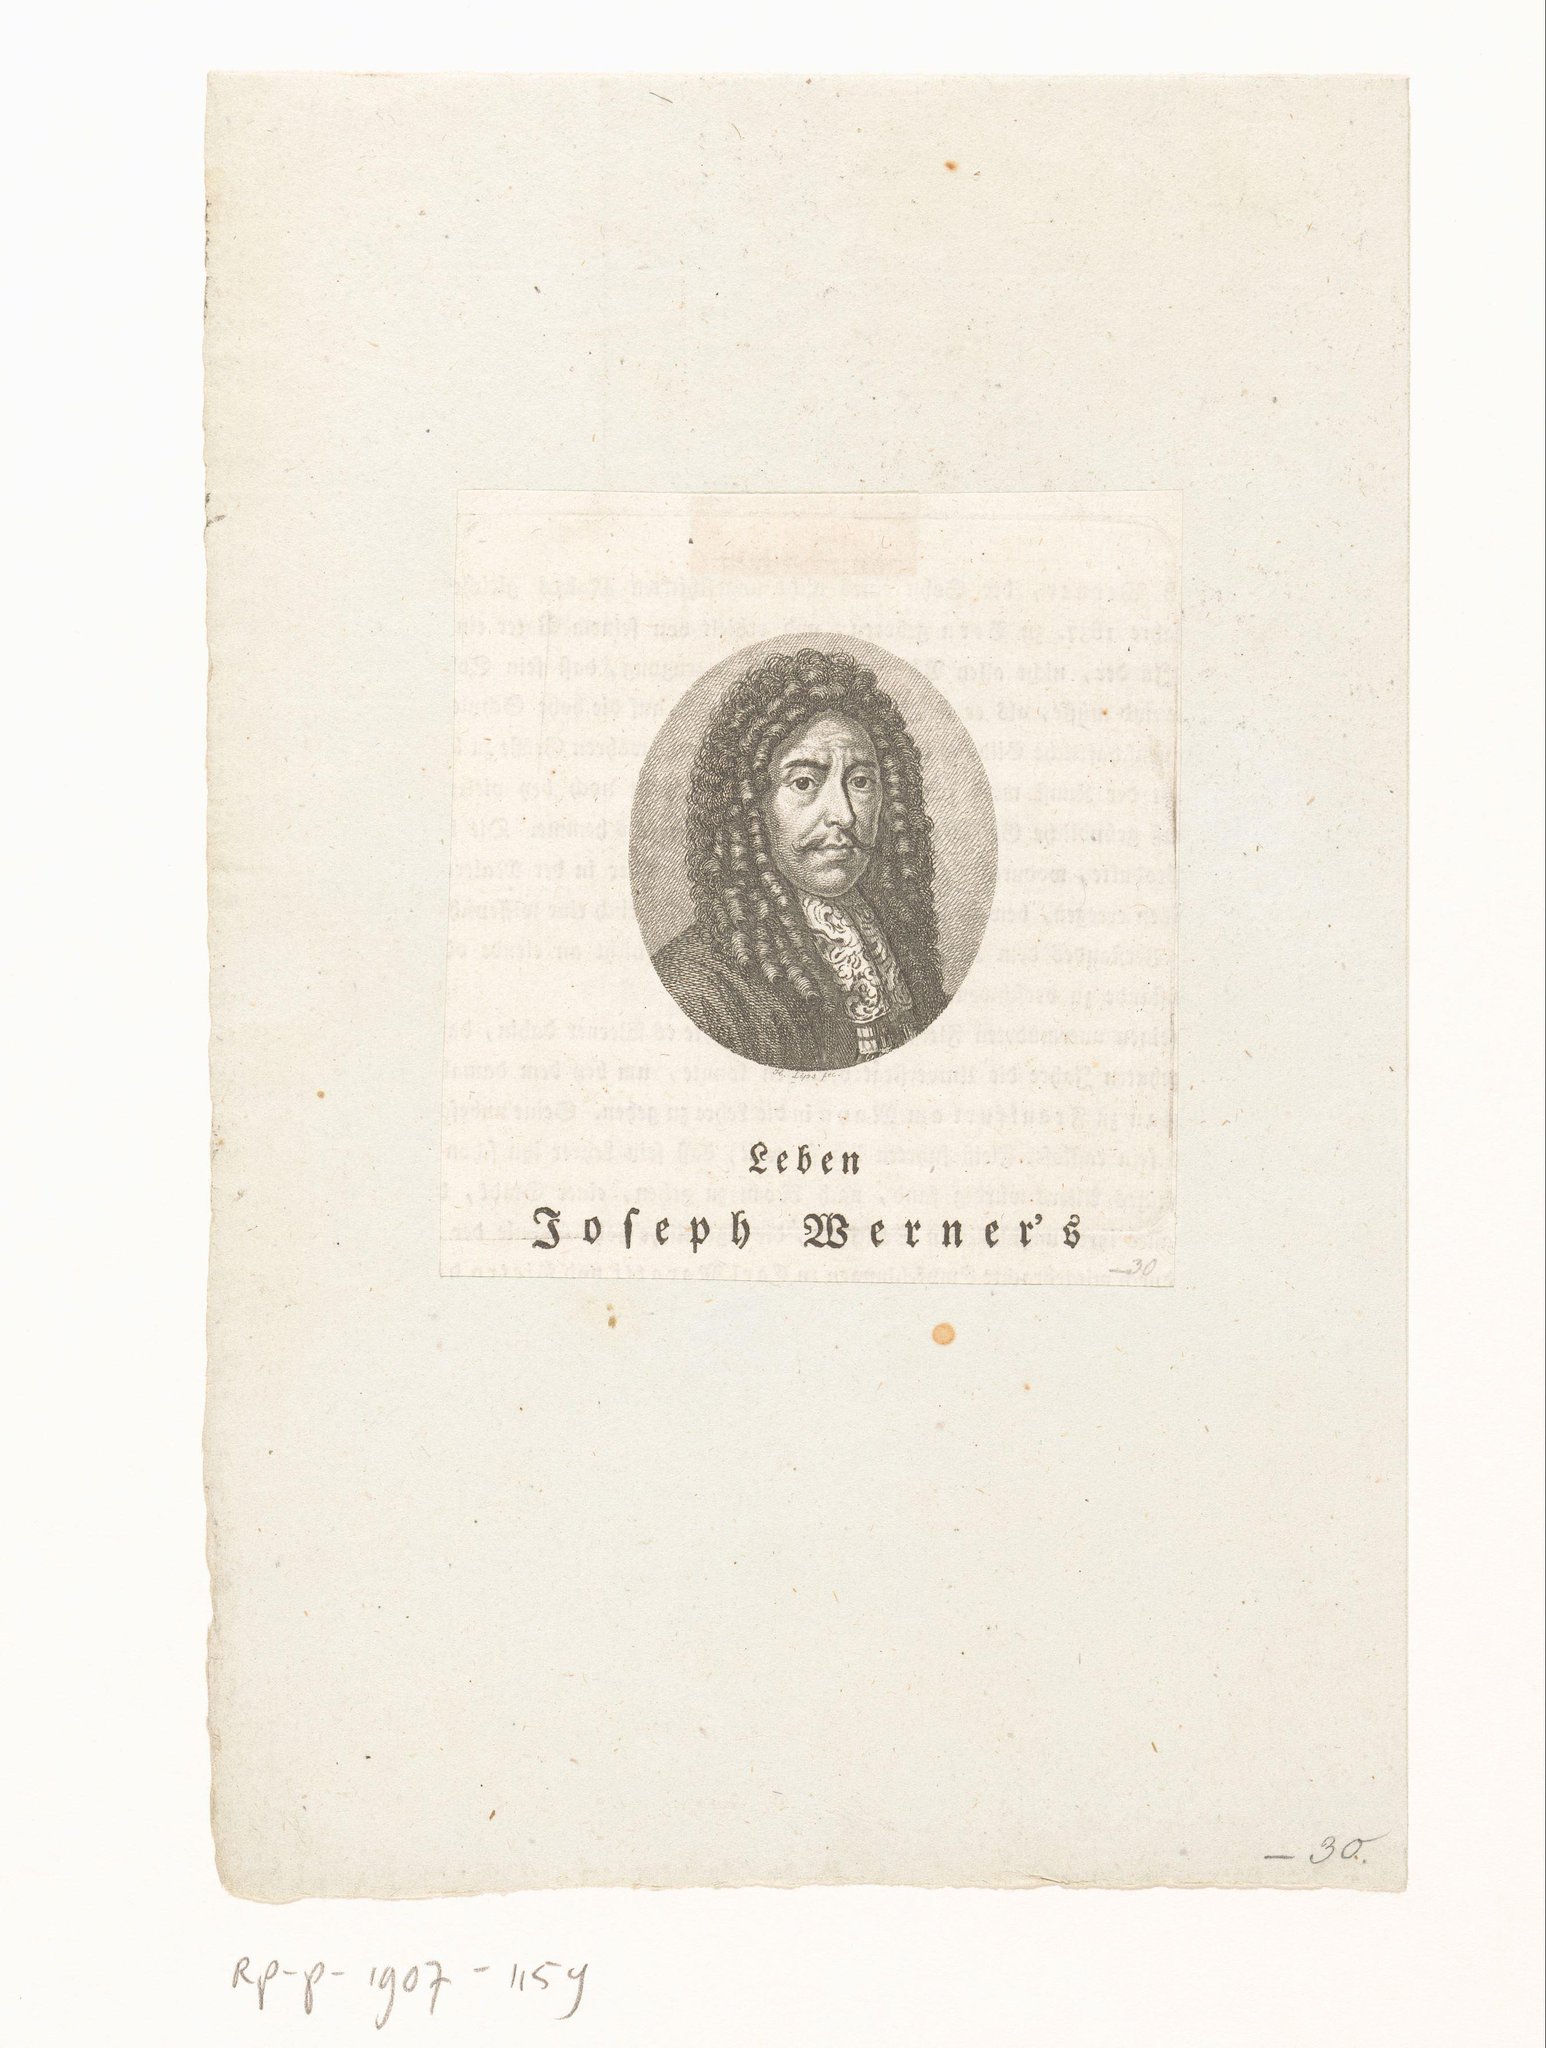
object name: print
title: Portret van Joseph Werner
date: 1805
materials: paper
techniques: engraving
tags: painter, joseph werner (ii), historical persons, portrait, self-portrait of artist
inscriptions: collector's mark: Lugt 2228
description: Prent afkomstig uit: Künstler-Gesellschaft in Zürich. Leben Joseph Werner's von Bern. Zürich: s.n., 1805.